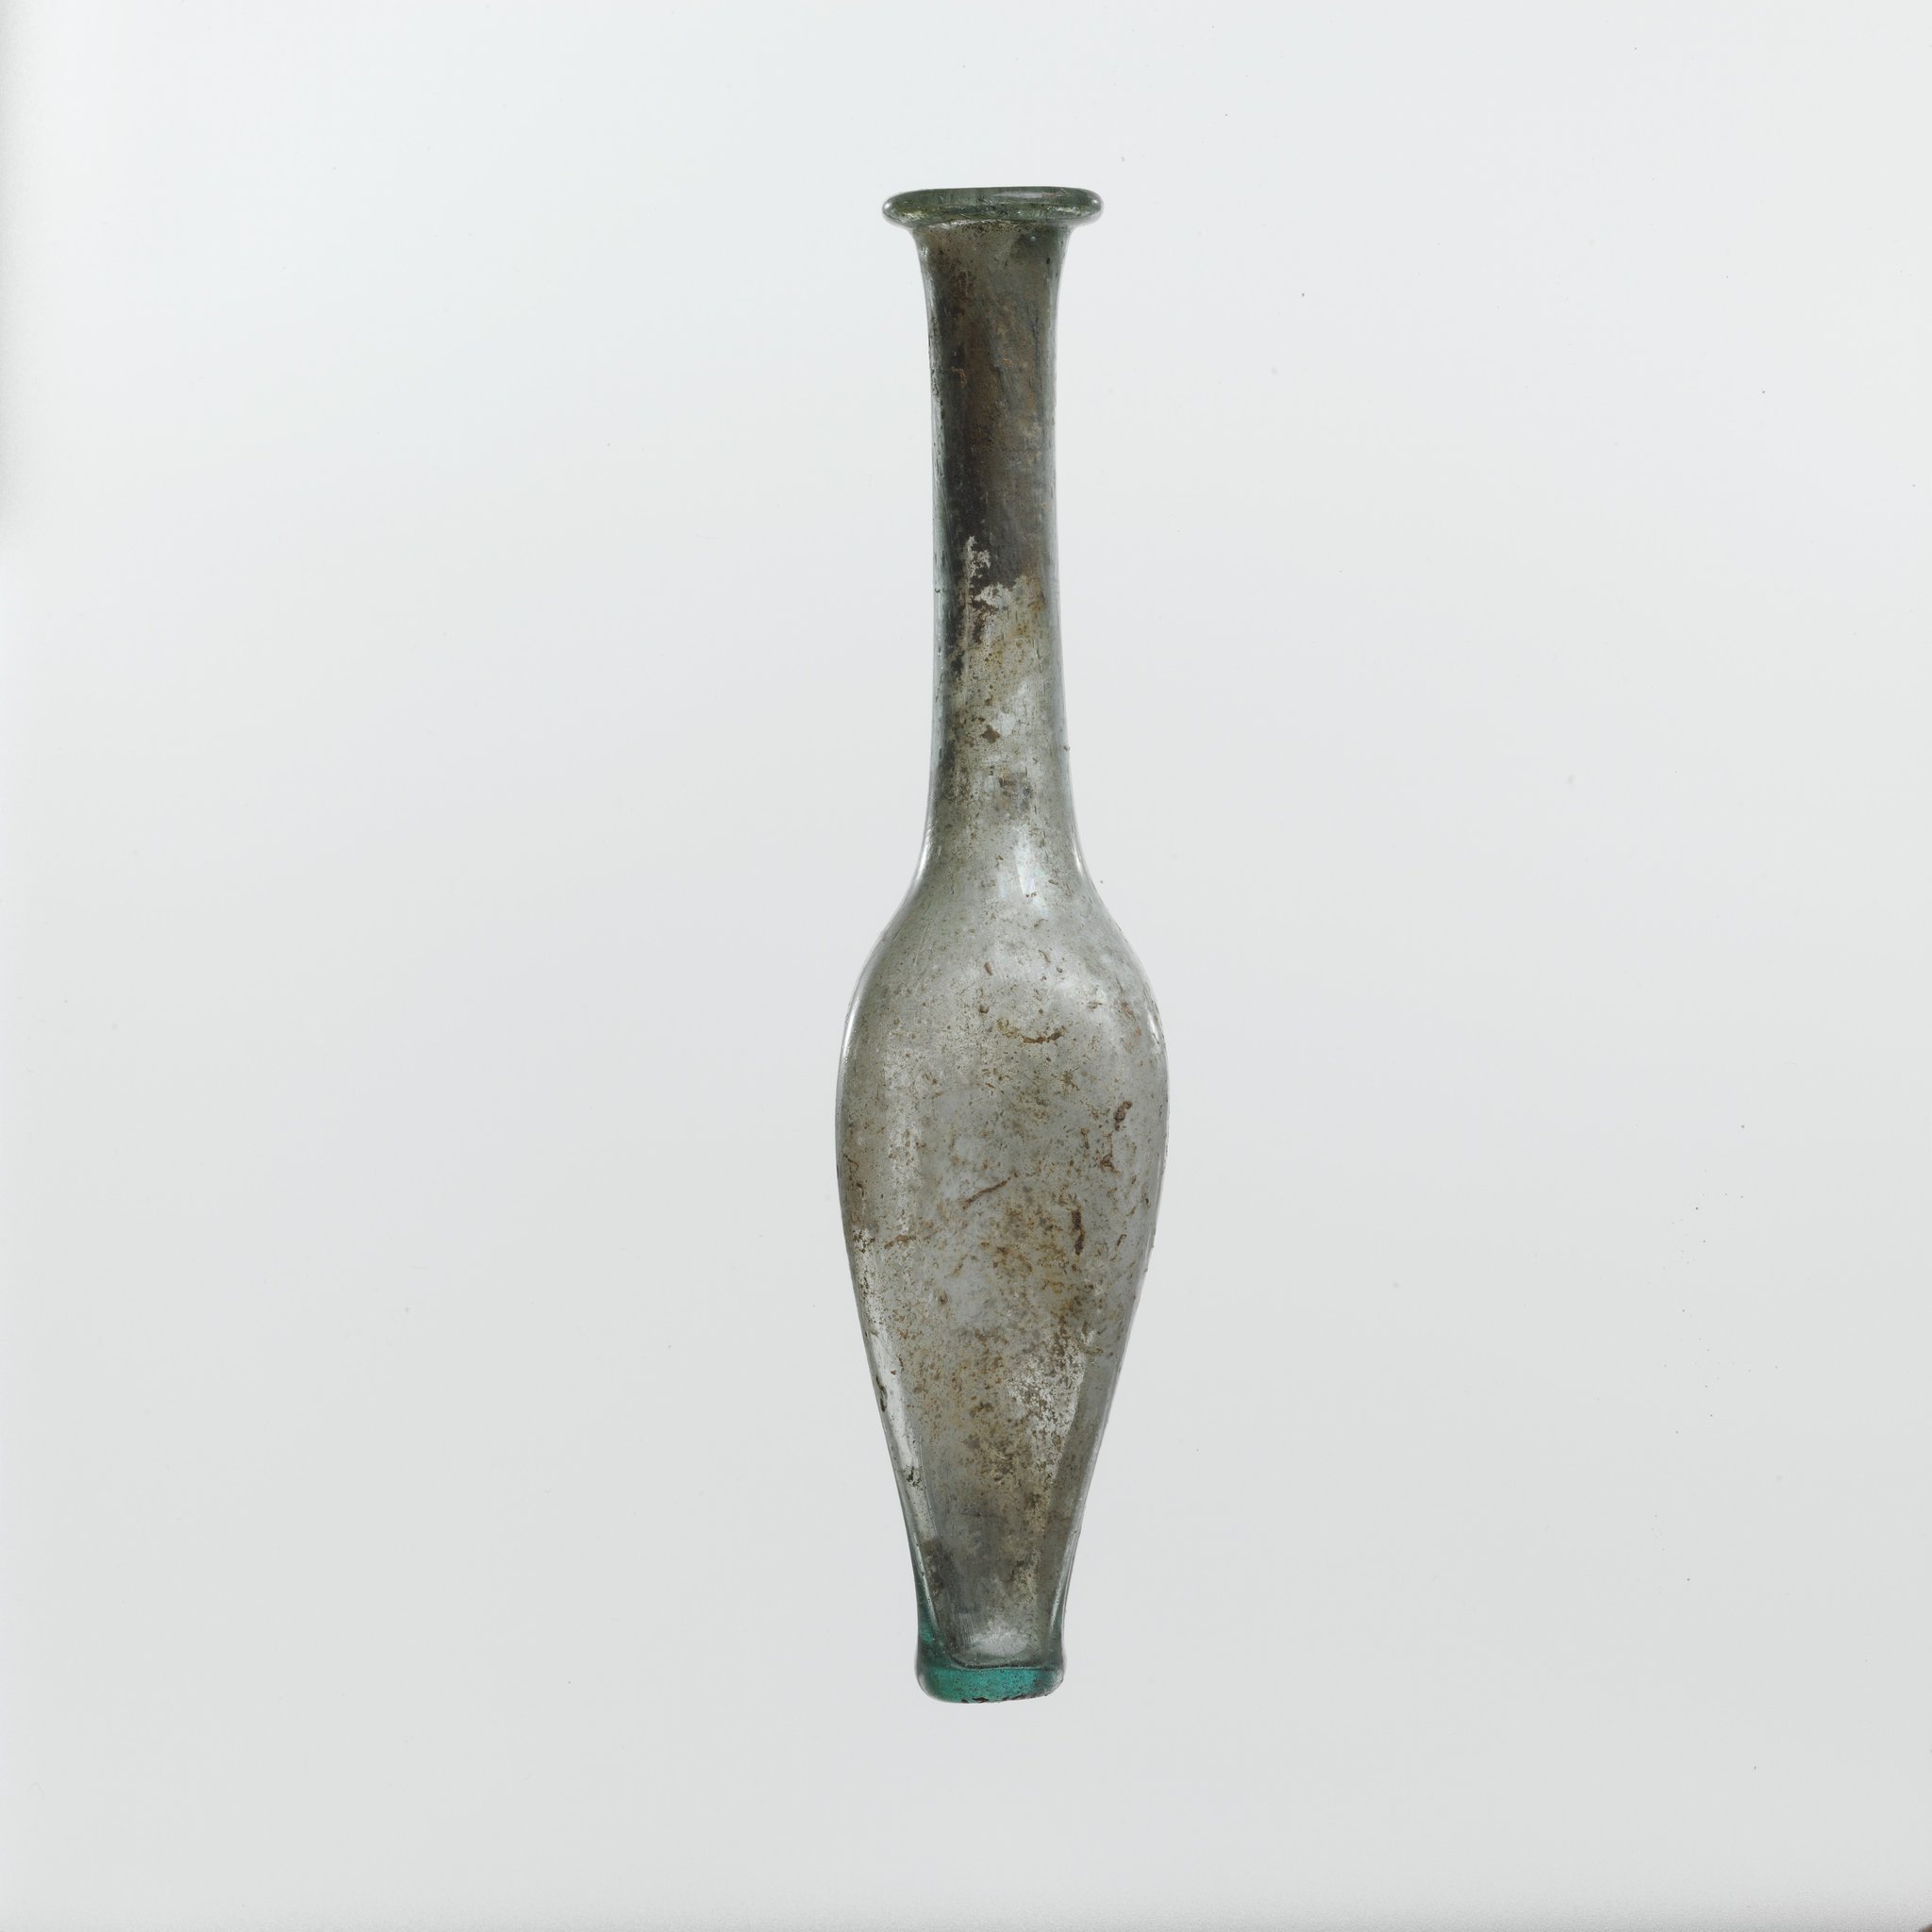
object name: bottle, indented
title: Glass bottle with indented side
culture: roman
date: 101-300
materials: glass